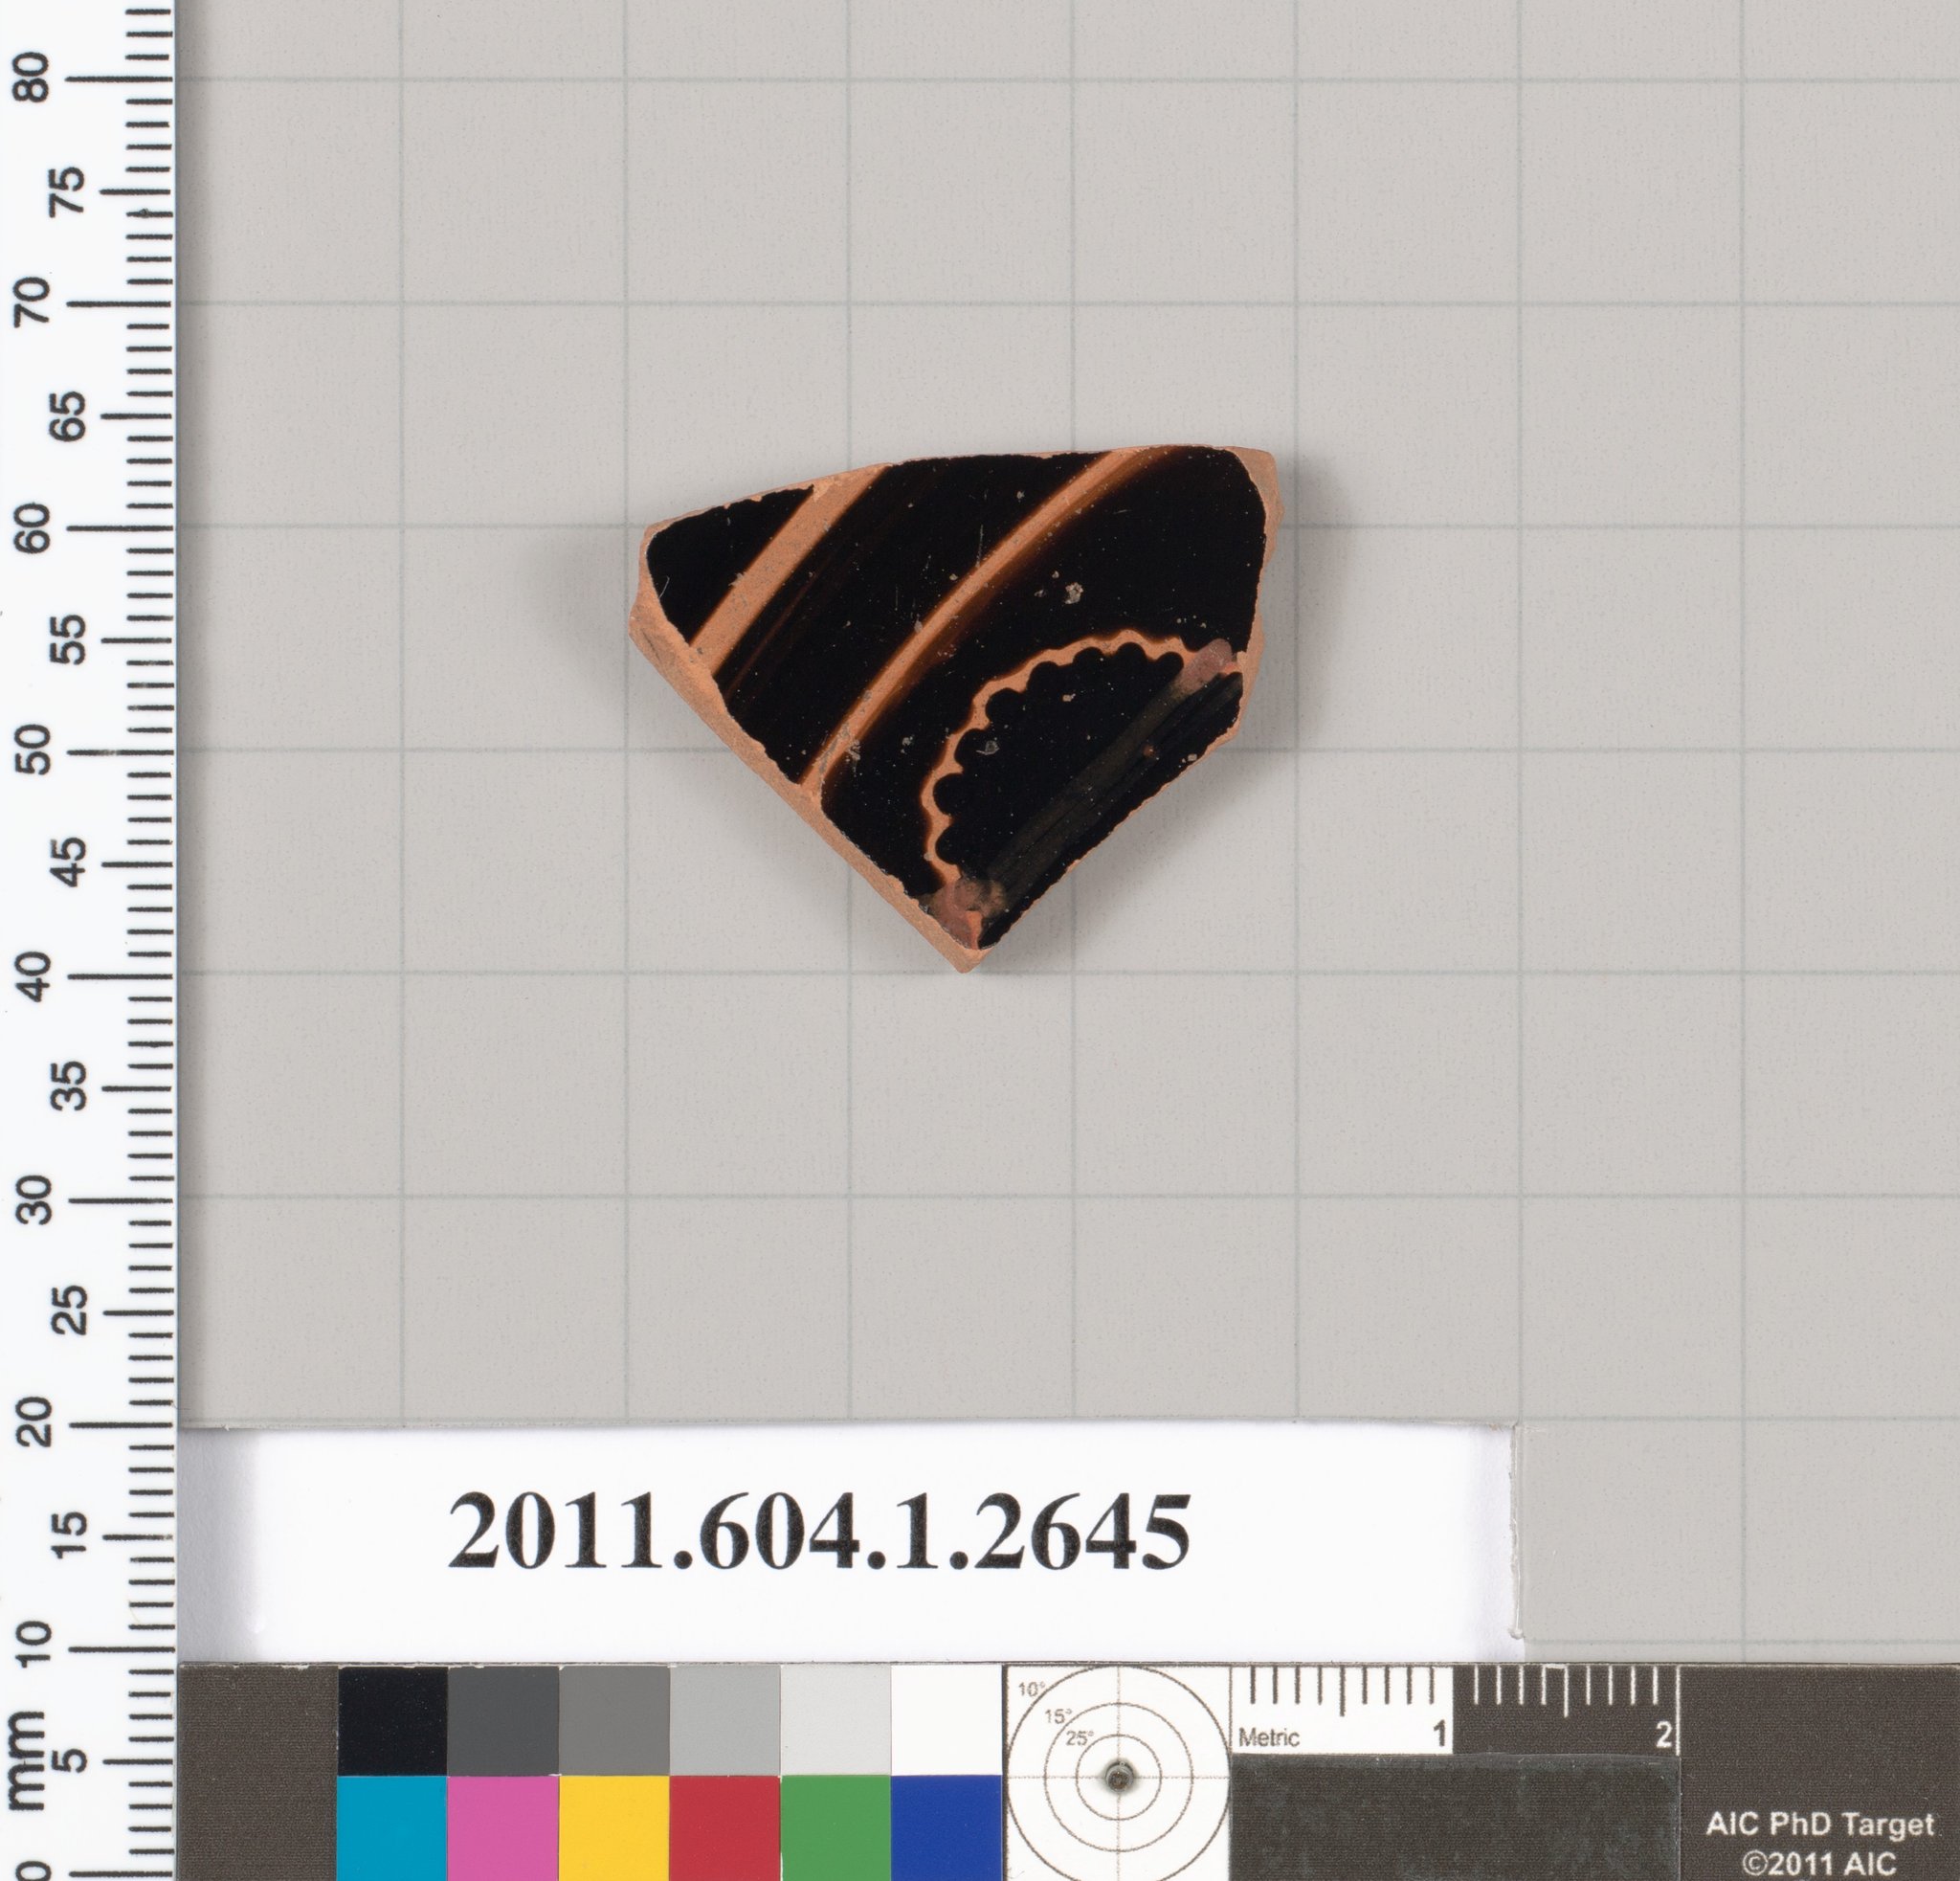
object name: kylix fragment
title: Terracotta fragment of a kylix (drinking cup)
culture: greek, attic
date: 520-500 BCE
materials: terracotta